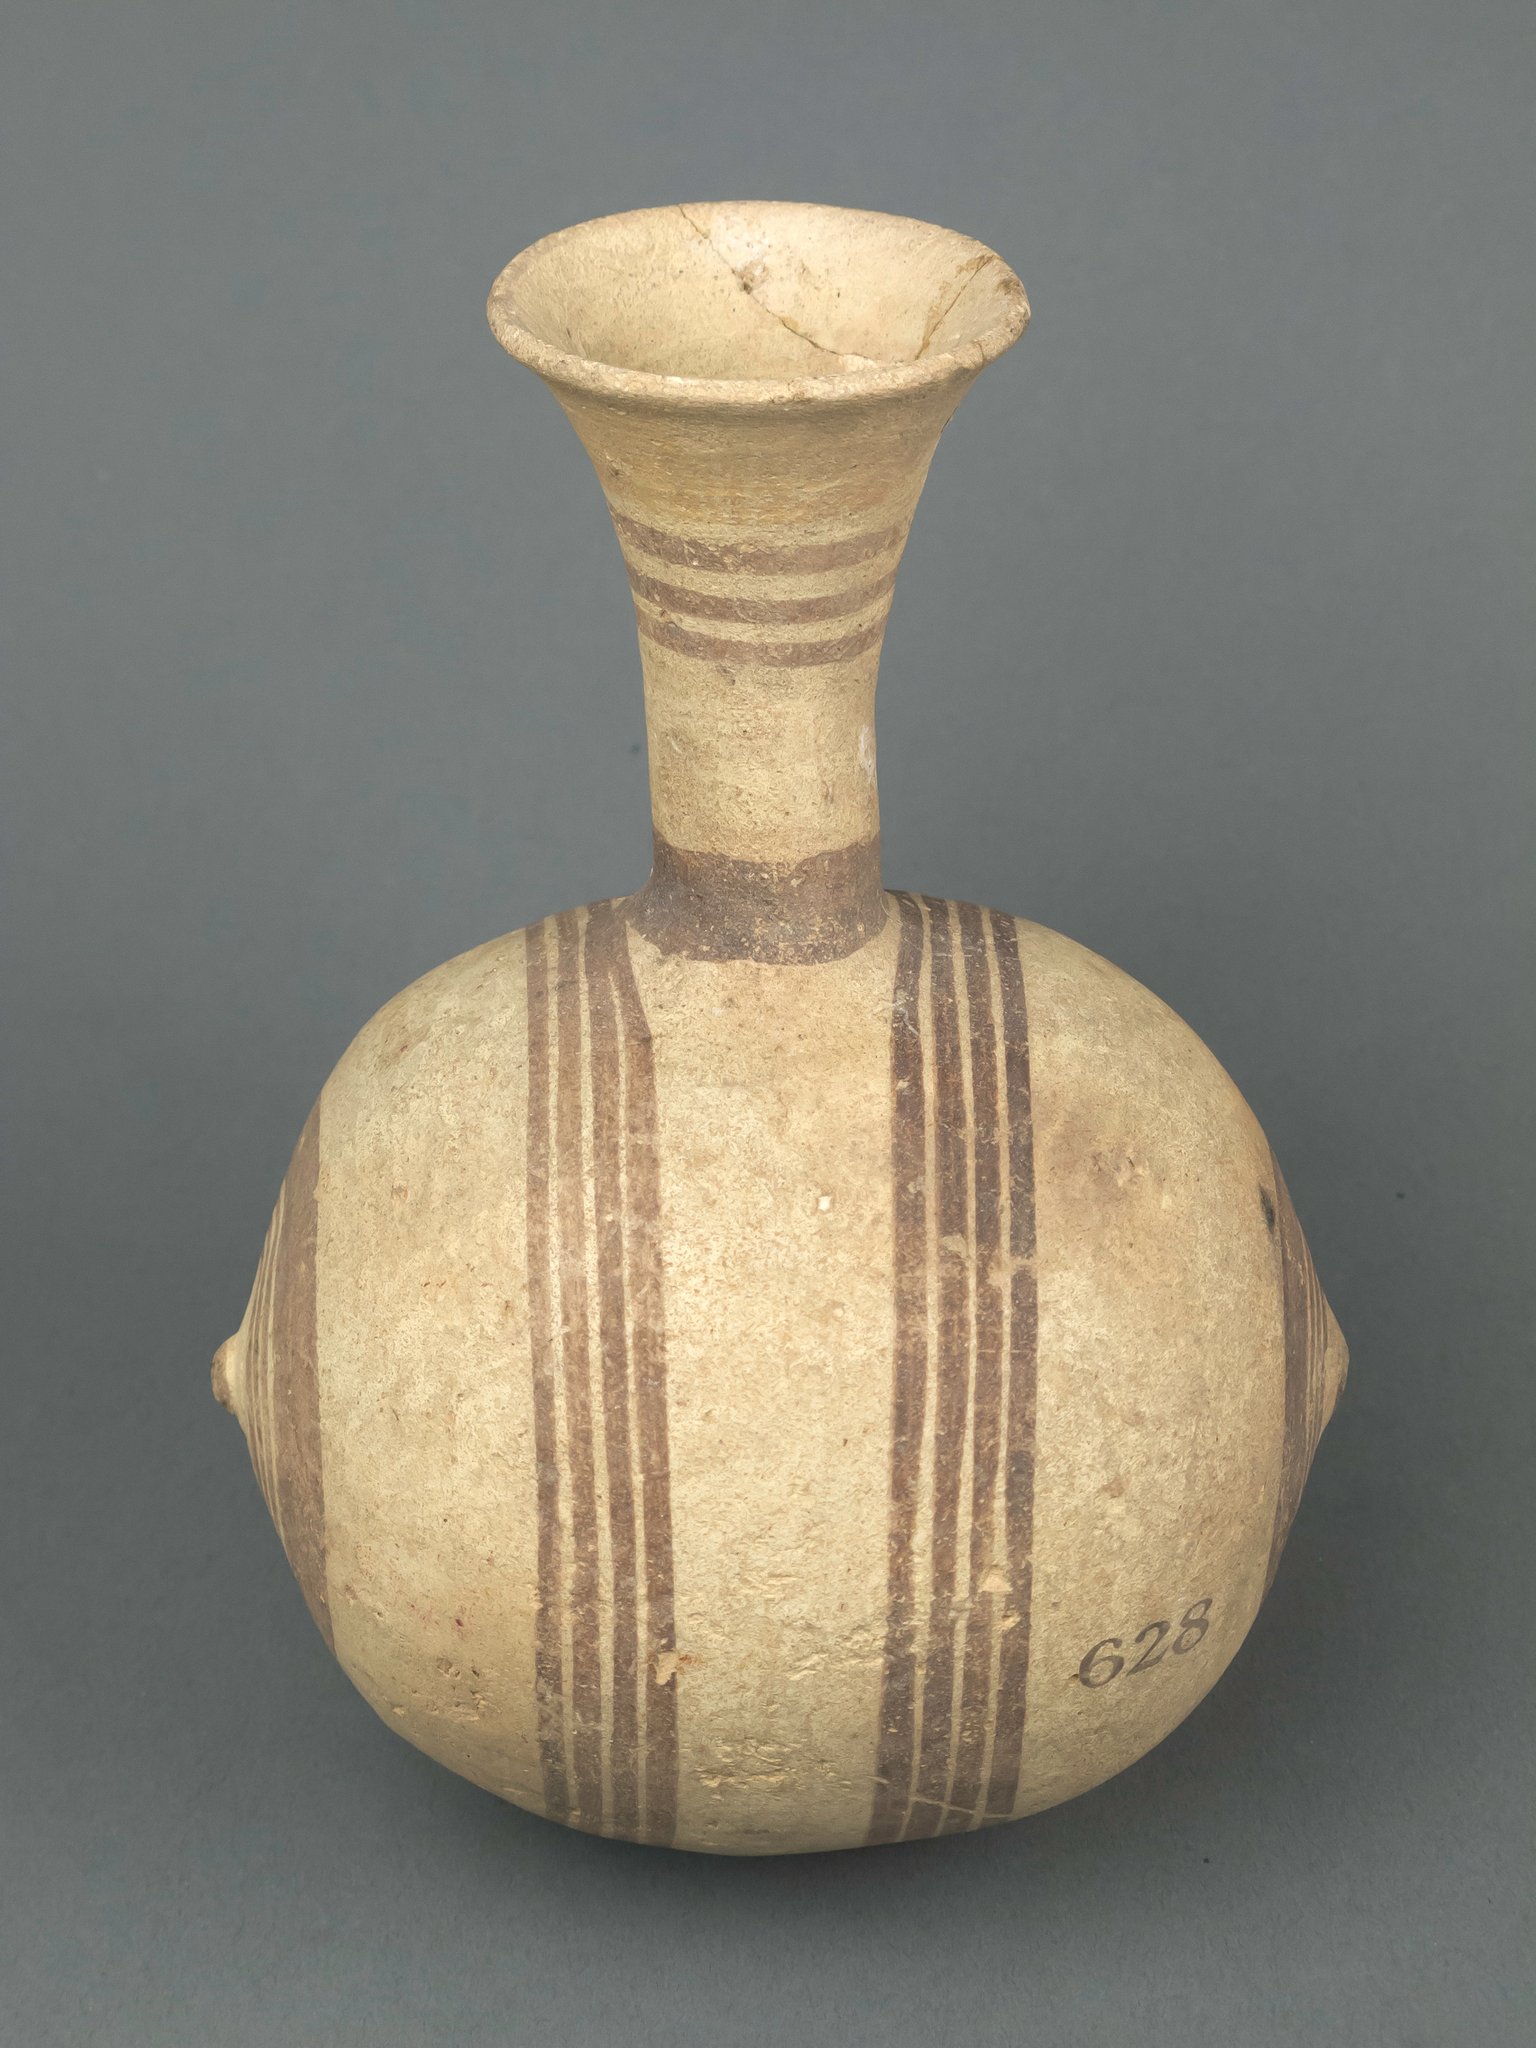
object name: jug, barrel shaped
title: Jug, barrel-shaped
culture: cypriot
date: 850-750 BCE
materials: terracotta